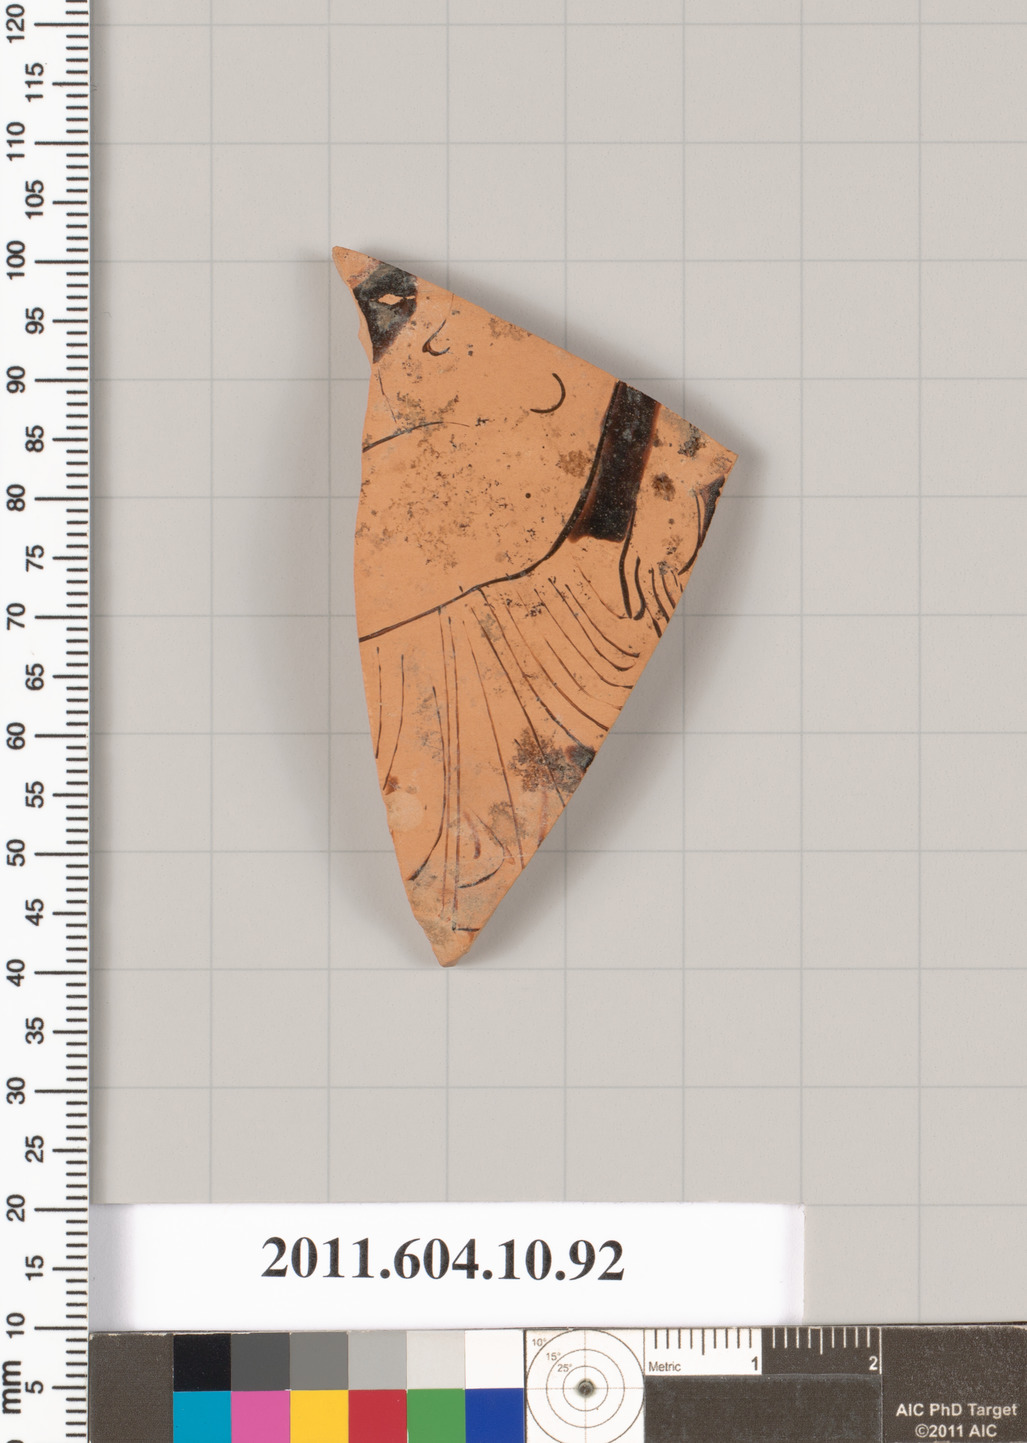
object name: undetermined closed shape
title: Terracotta fragment of a closed shape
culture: etruscan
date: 400-301 BCE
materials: terracotta